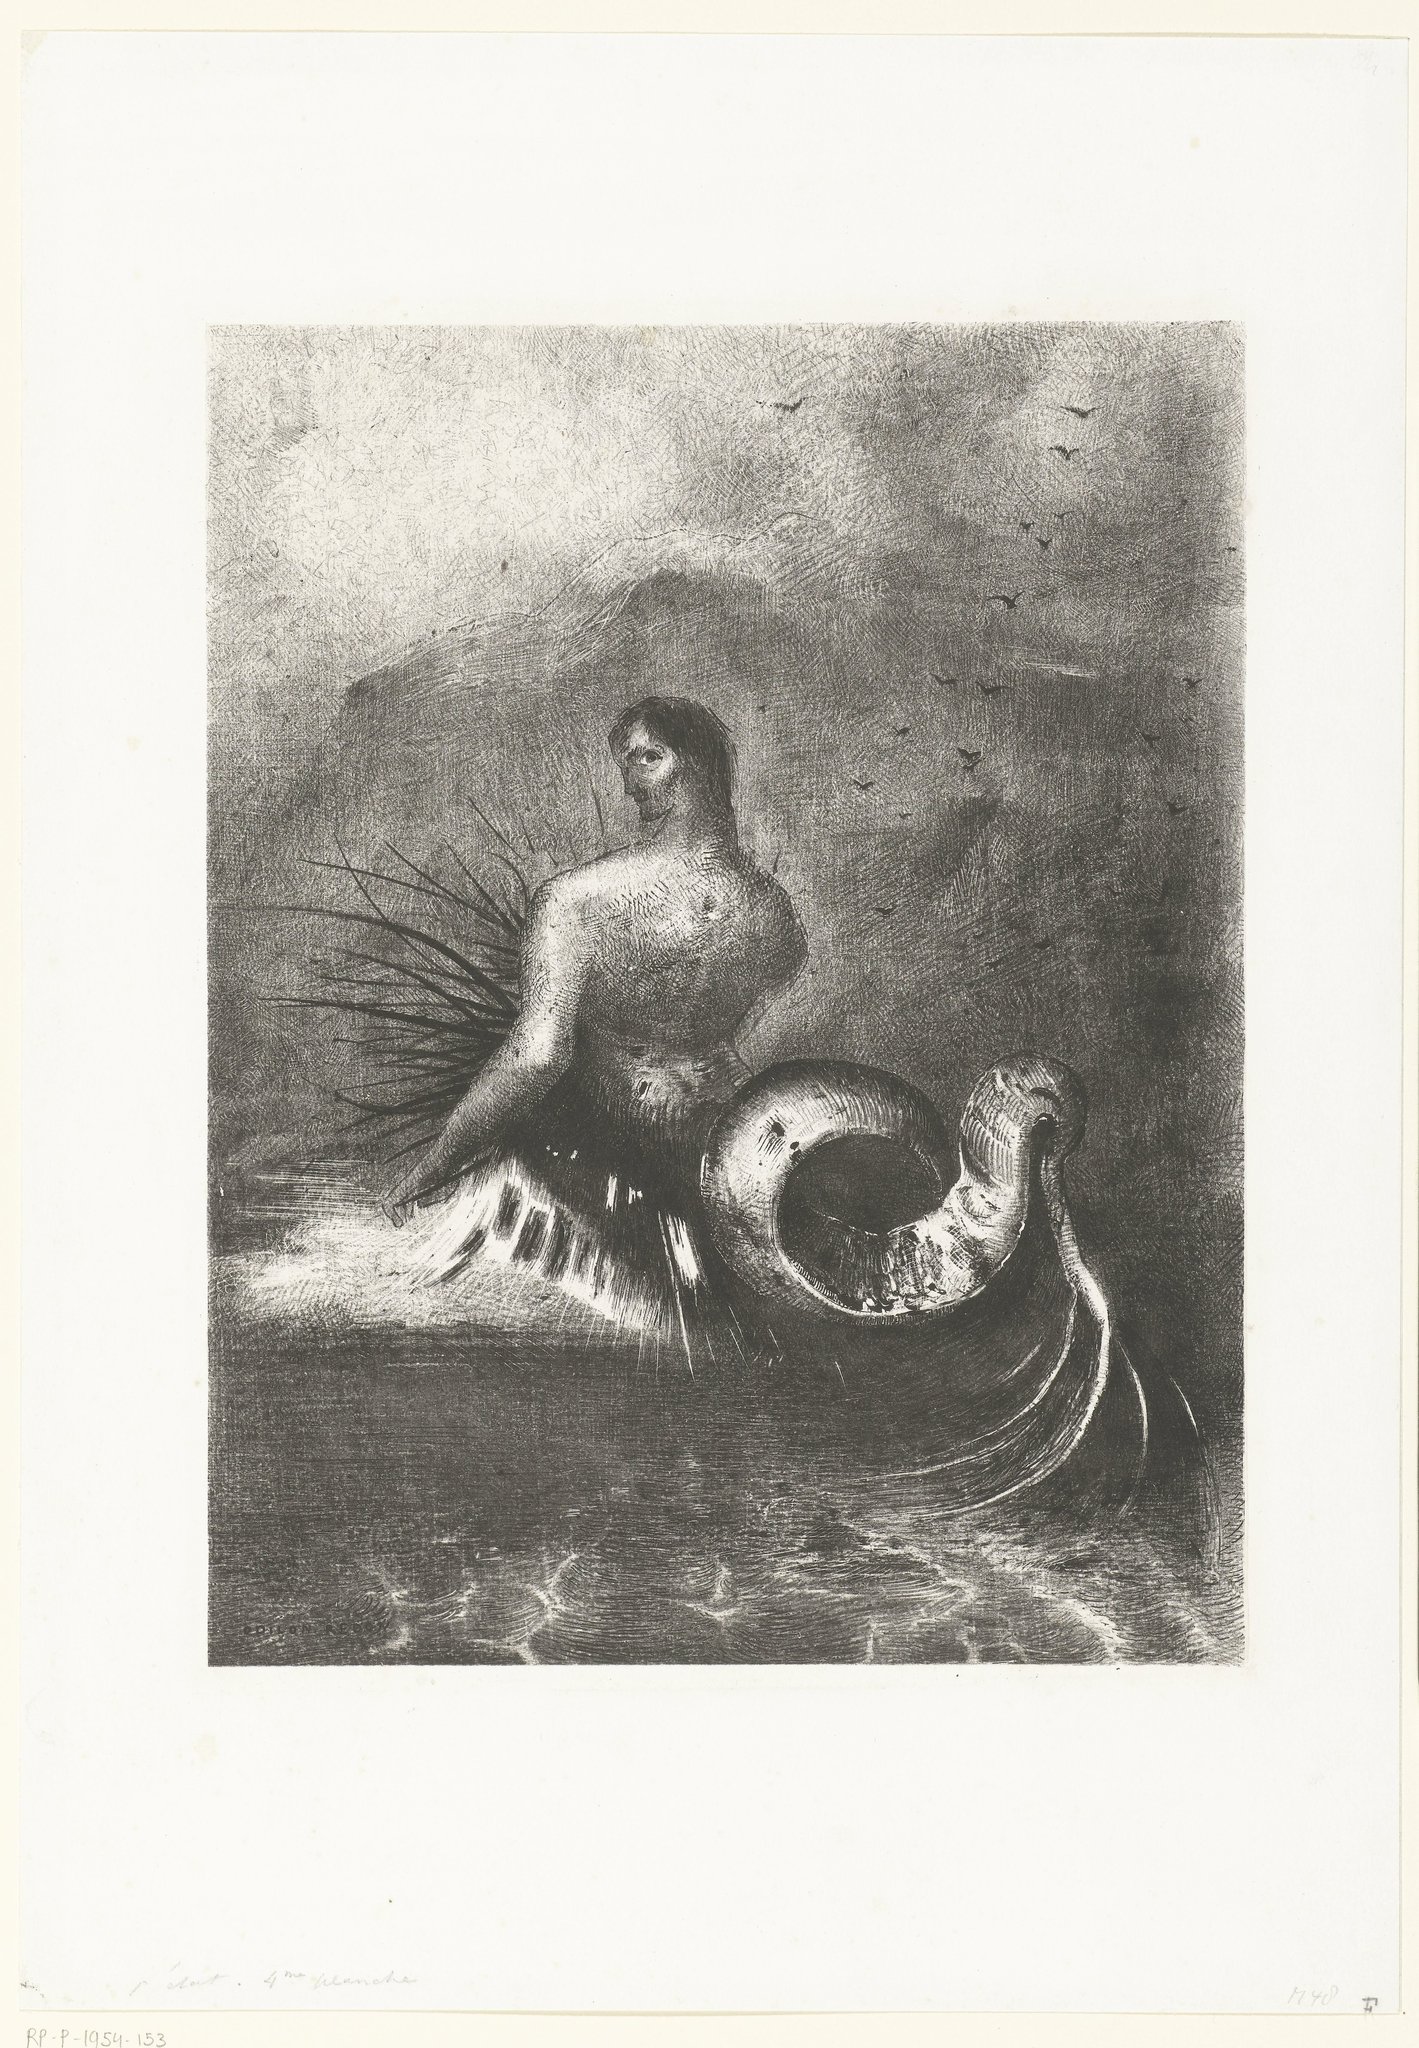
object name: print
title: De oorsprongen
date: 1883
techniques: printmaking, lithograph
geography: paris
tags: merman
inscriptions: collector's mark: Lugt 2760, collector's mark: Lugt 2228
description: Een menselijk figuur met een vissenstraat, op de rug gezien, boven het zeewater. Vierde prent uit een serie van acht.